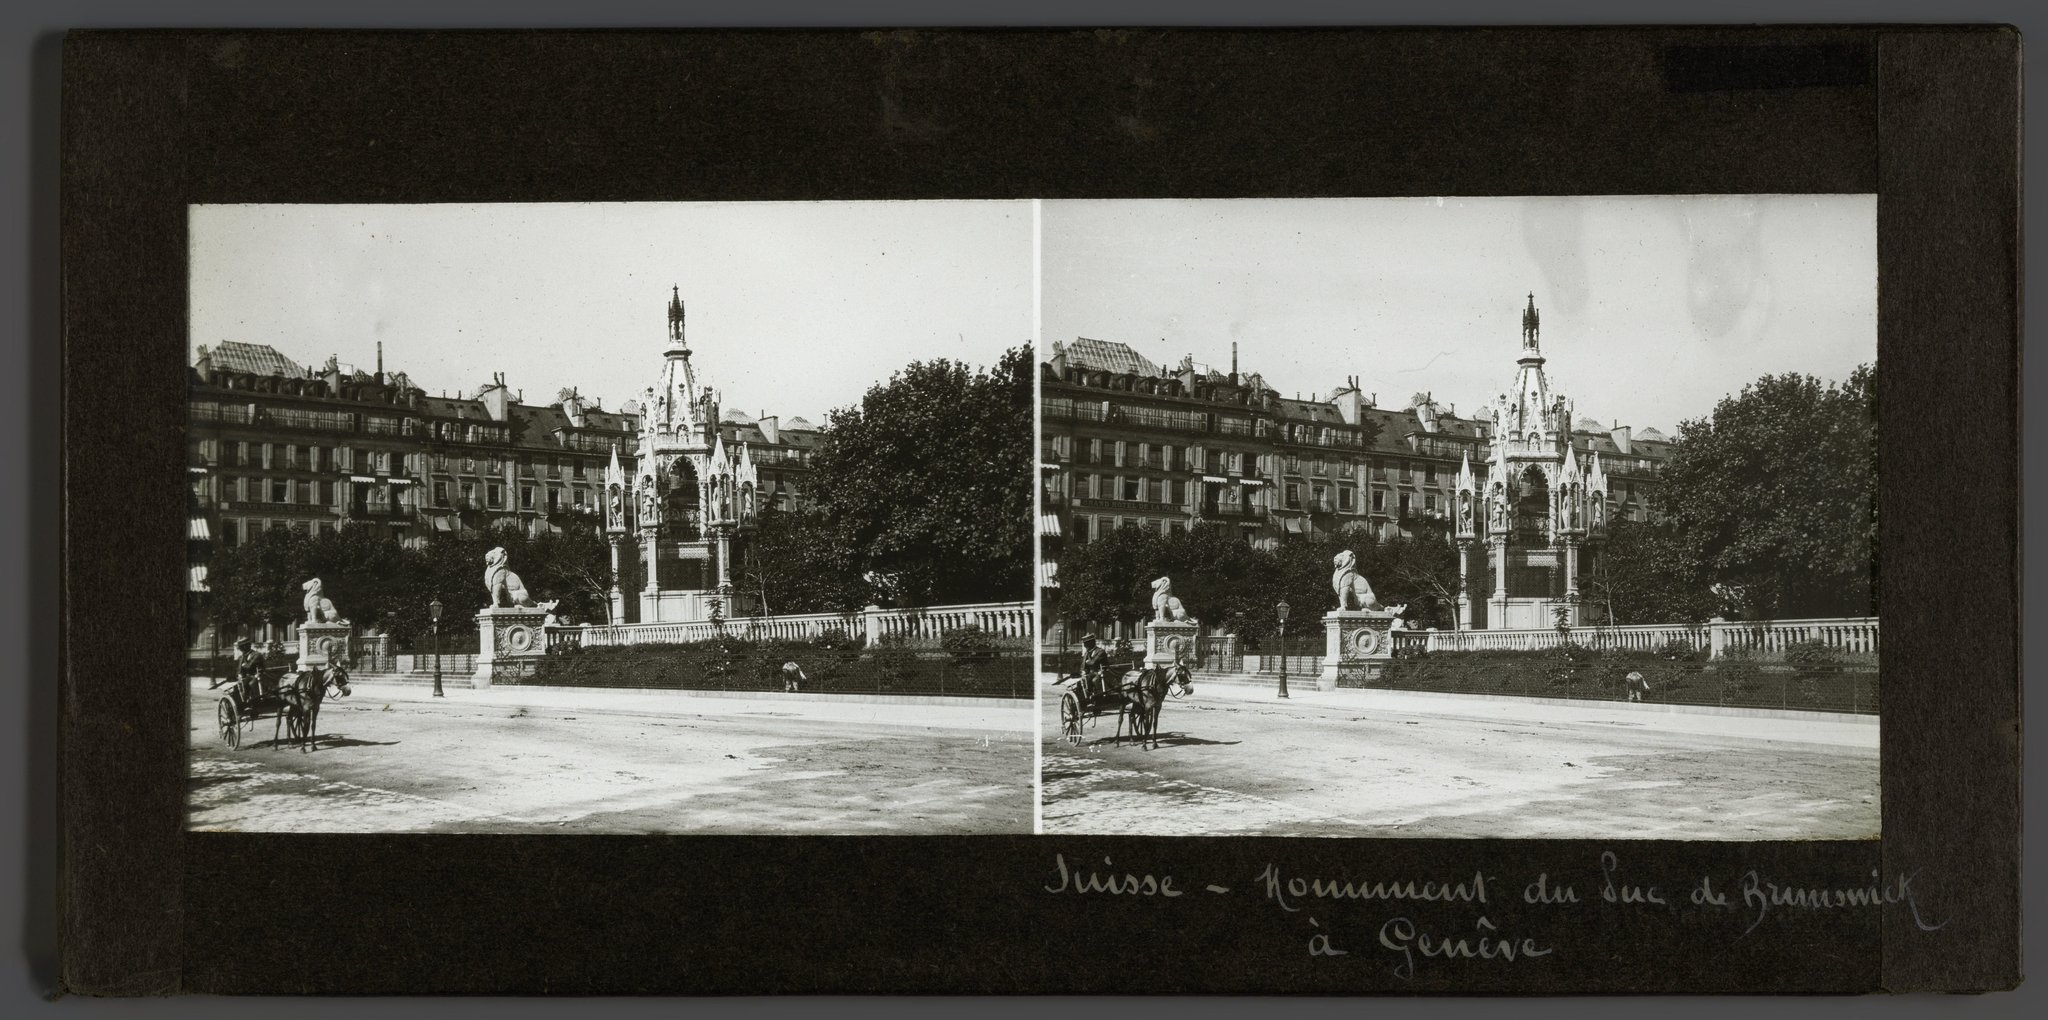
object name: stereoscopic photograph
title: Suisse - Monument du Duc de Brunswick, à Genève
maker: Anonymous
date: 1880-1900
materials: glass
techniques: slide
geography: geneva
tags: monument, statue